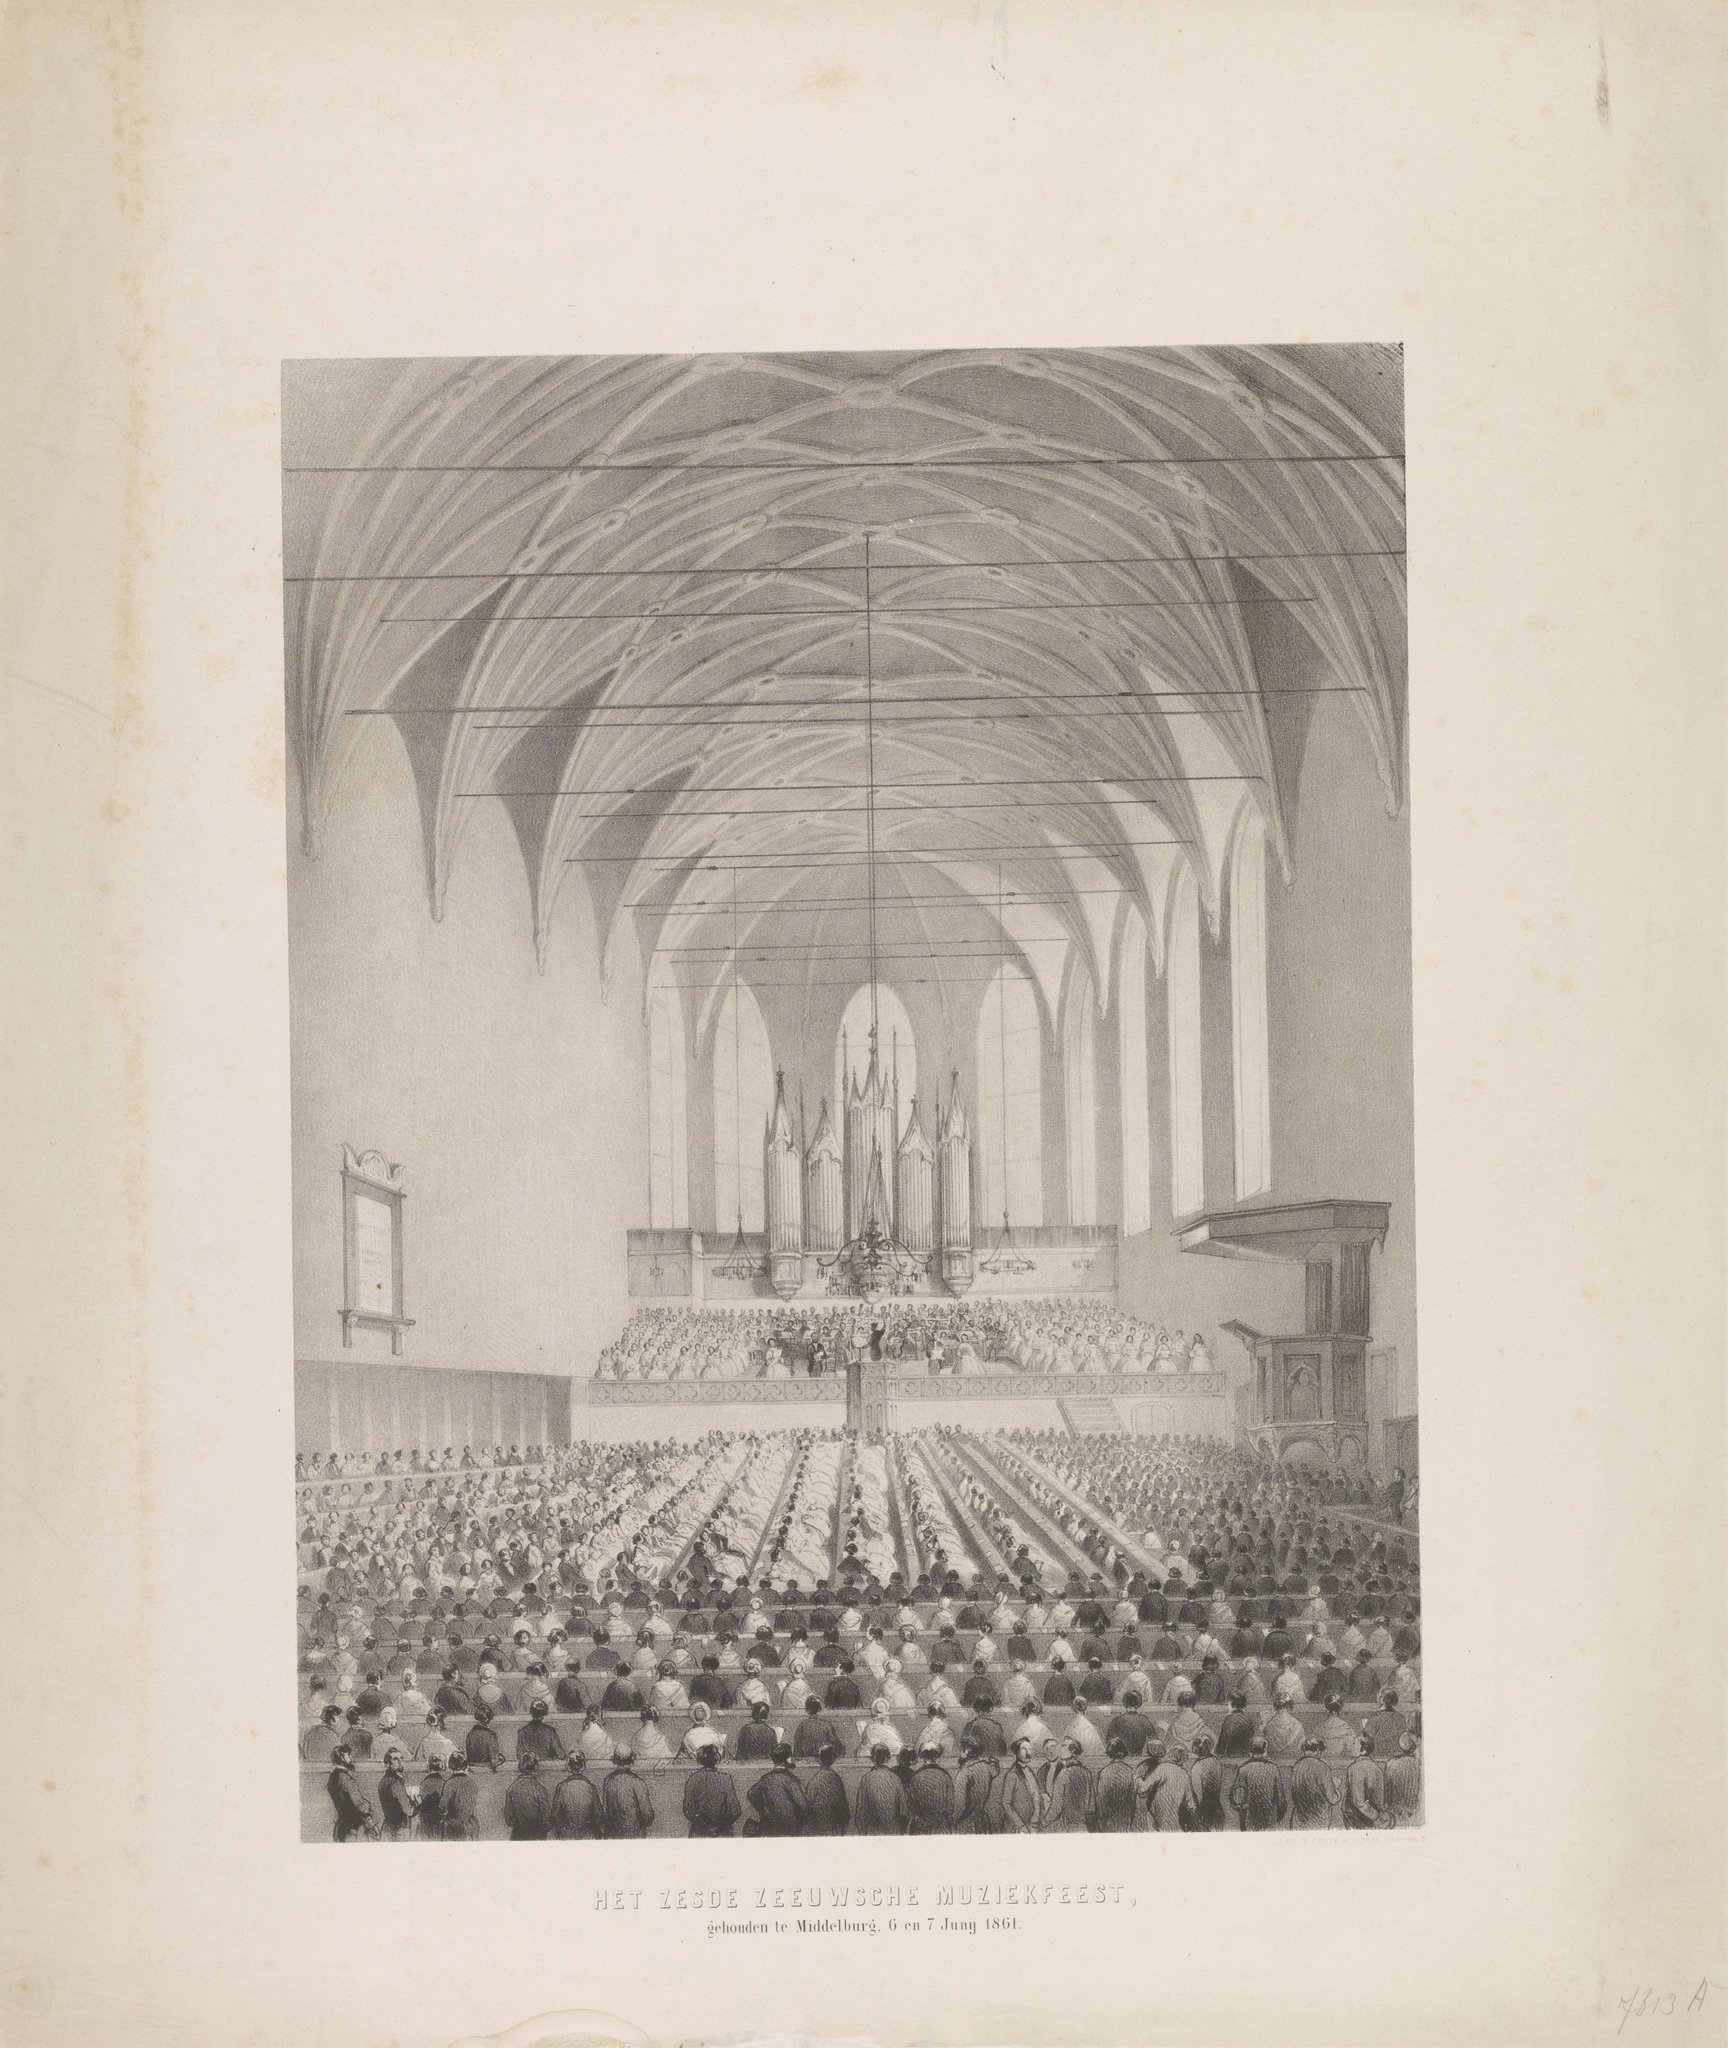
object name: print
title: Het Zesde Zeeuwsche Muziekfeest, gehouden te Middelburg, 6 en 7 Junij 1861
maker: Anonymous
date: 1861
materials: paper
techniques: lithograph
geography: haarlem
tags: choir (in church), interior of church, choir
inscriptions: collector's mark: Lugt 2228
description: Gezicht in de Koorkerk te Middelburg waar het Zesde Zeeuwsche Muziekfeest wordt gehouden, 6-7 juni 1861. Onder het orgel leidt de dirgent een orkest en koor. Op de voorgrond rijen met toeschouwers.